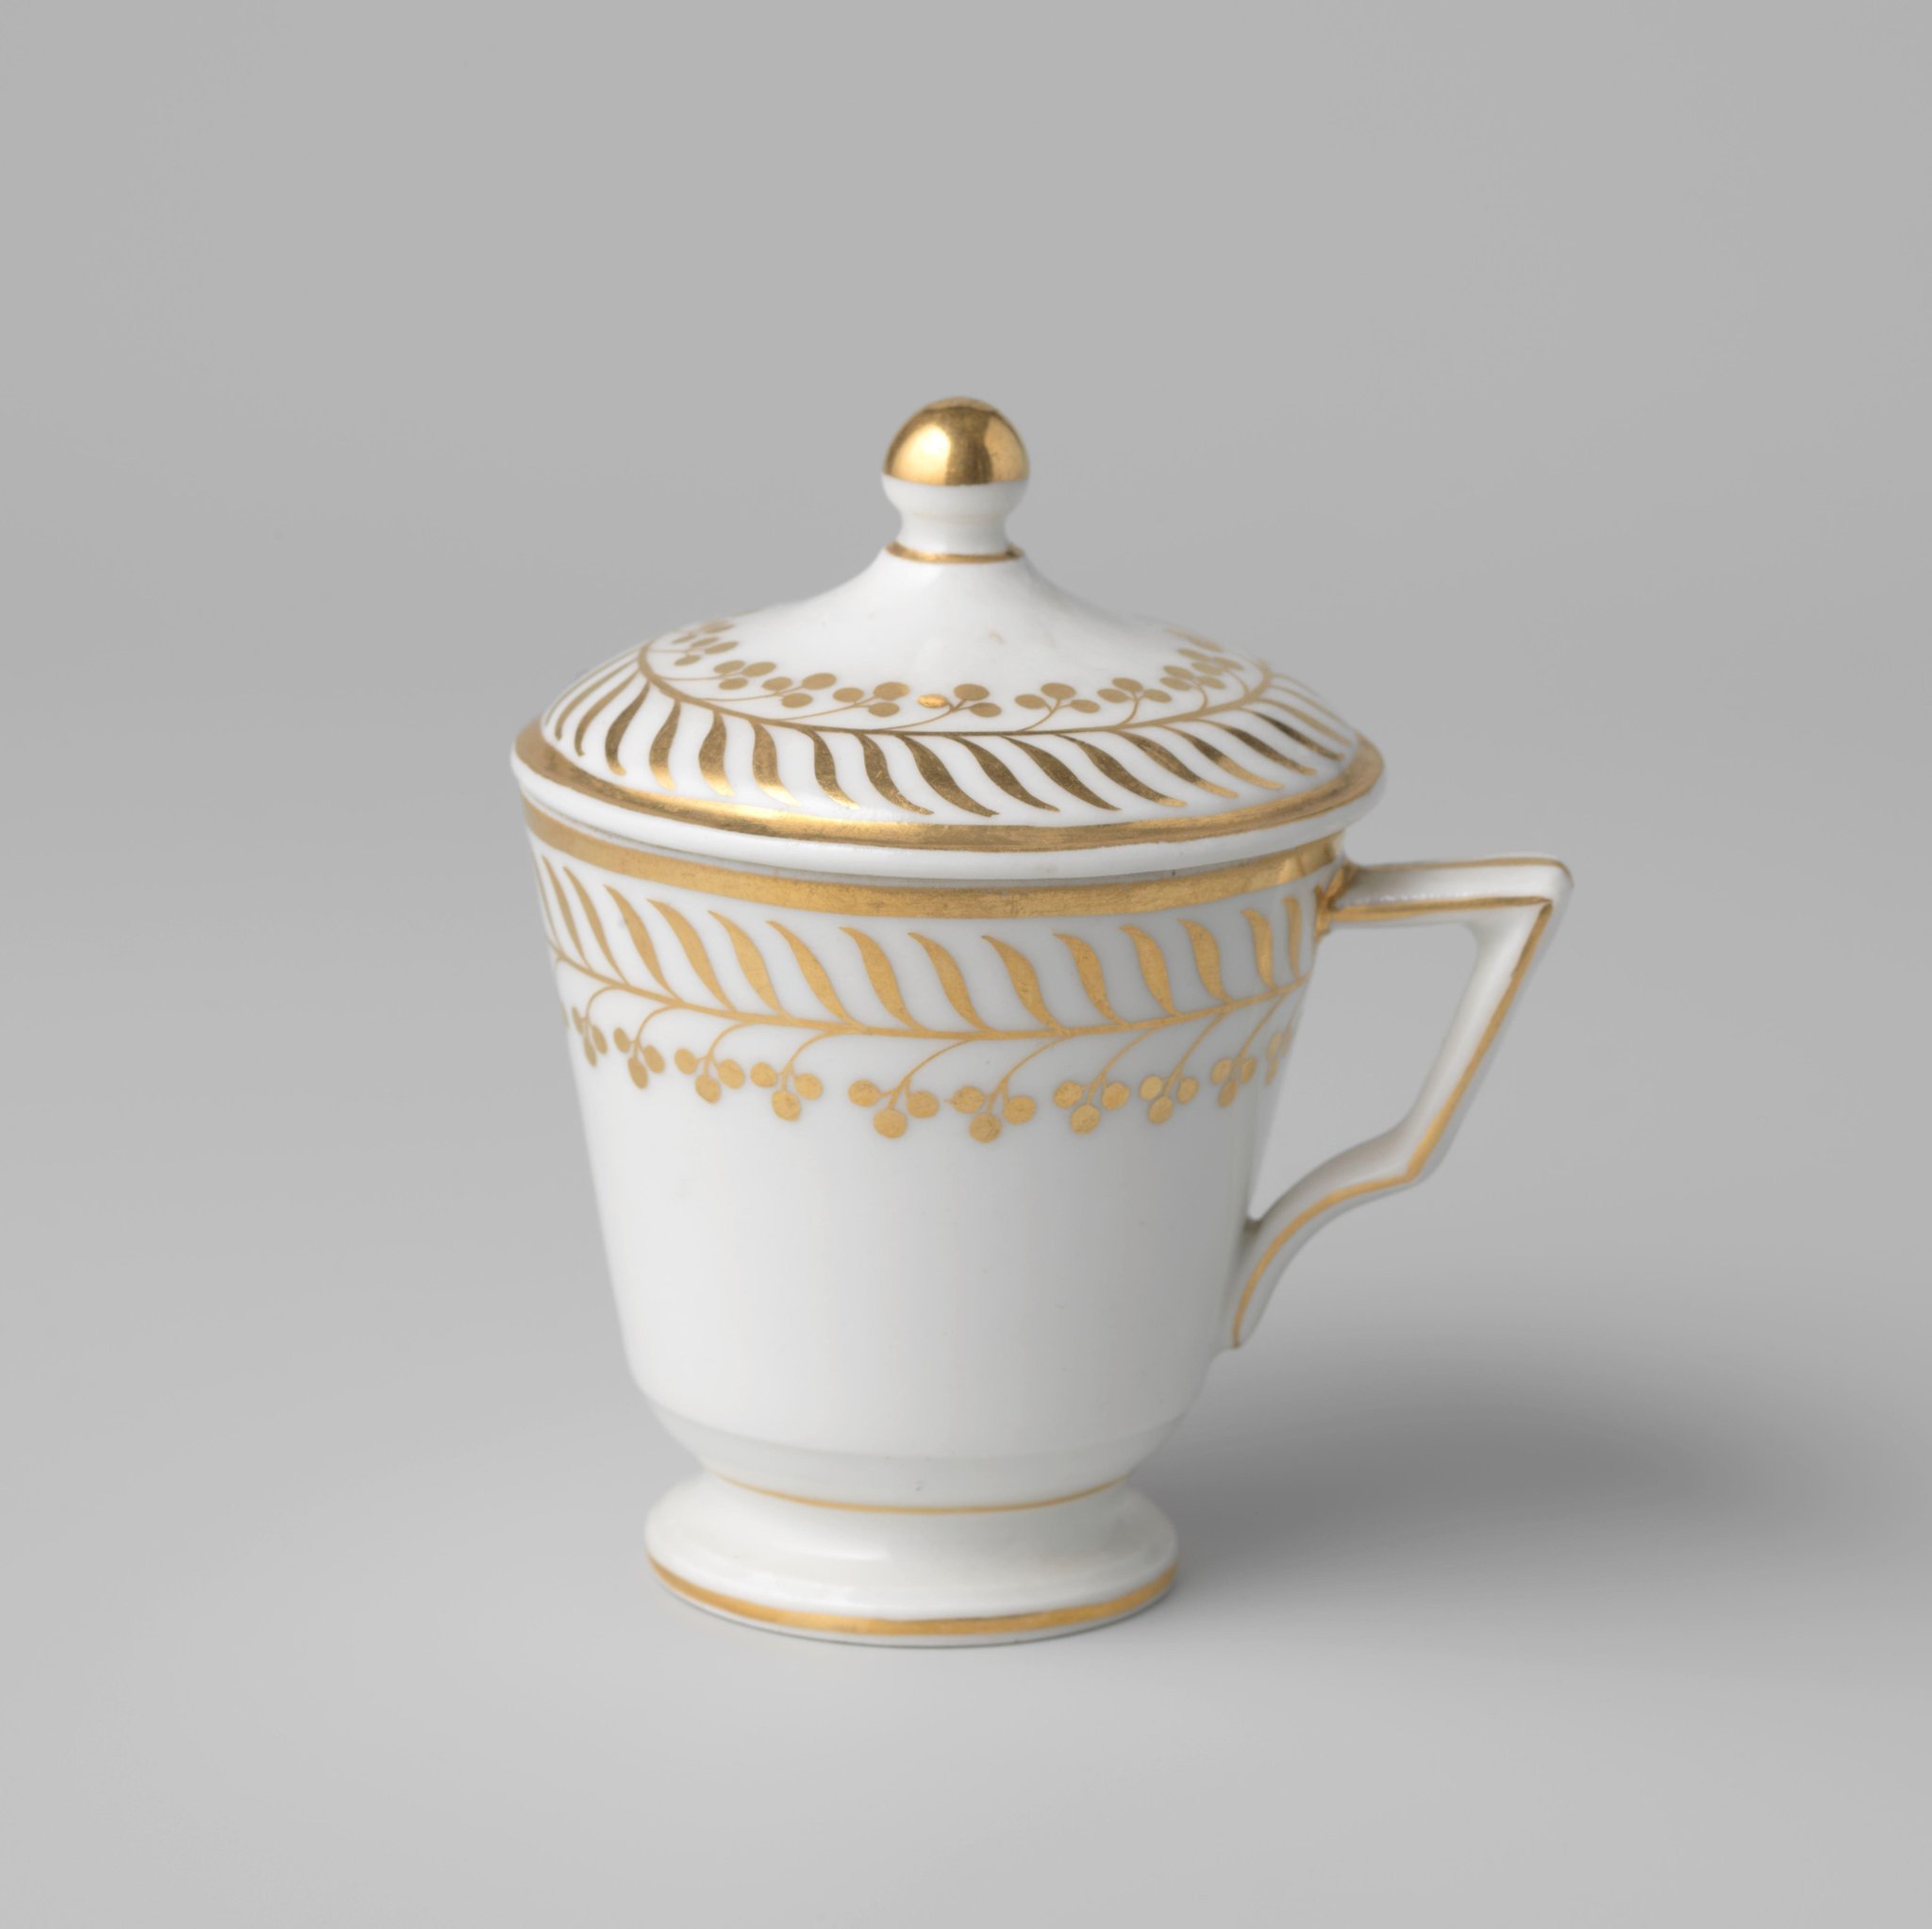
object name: covered cup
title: Cover of a cup (pot de crème) with stylized floral scrolls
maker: Anonymous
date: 1800-1810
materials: glaze, gold, paint, porcelain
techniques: firing, forming, gilding, vitrification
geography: france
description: Deksel van porselein waarop een vergulde knop. Versierd met gouden biezen en langs de randen beschilderd met een doorlopende tak met aan de ene zijde bladeren, aan de andere zijde steeds een tak met drie vruchten.